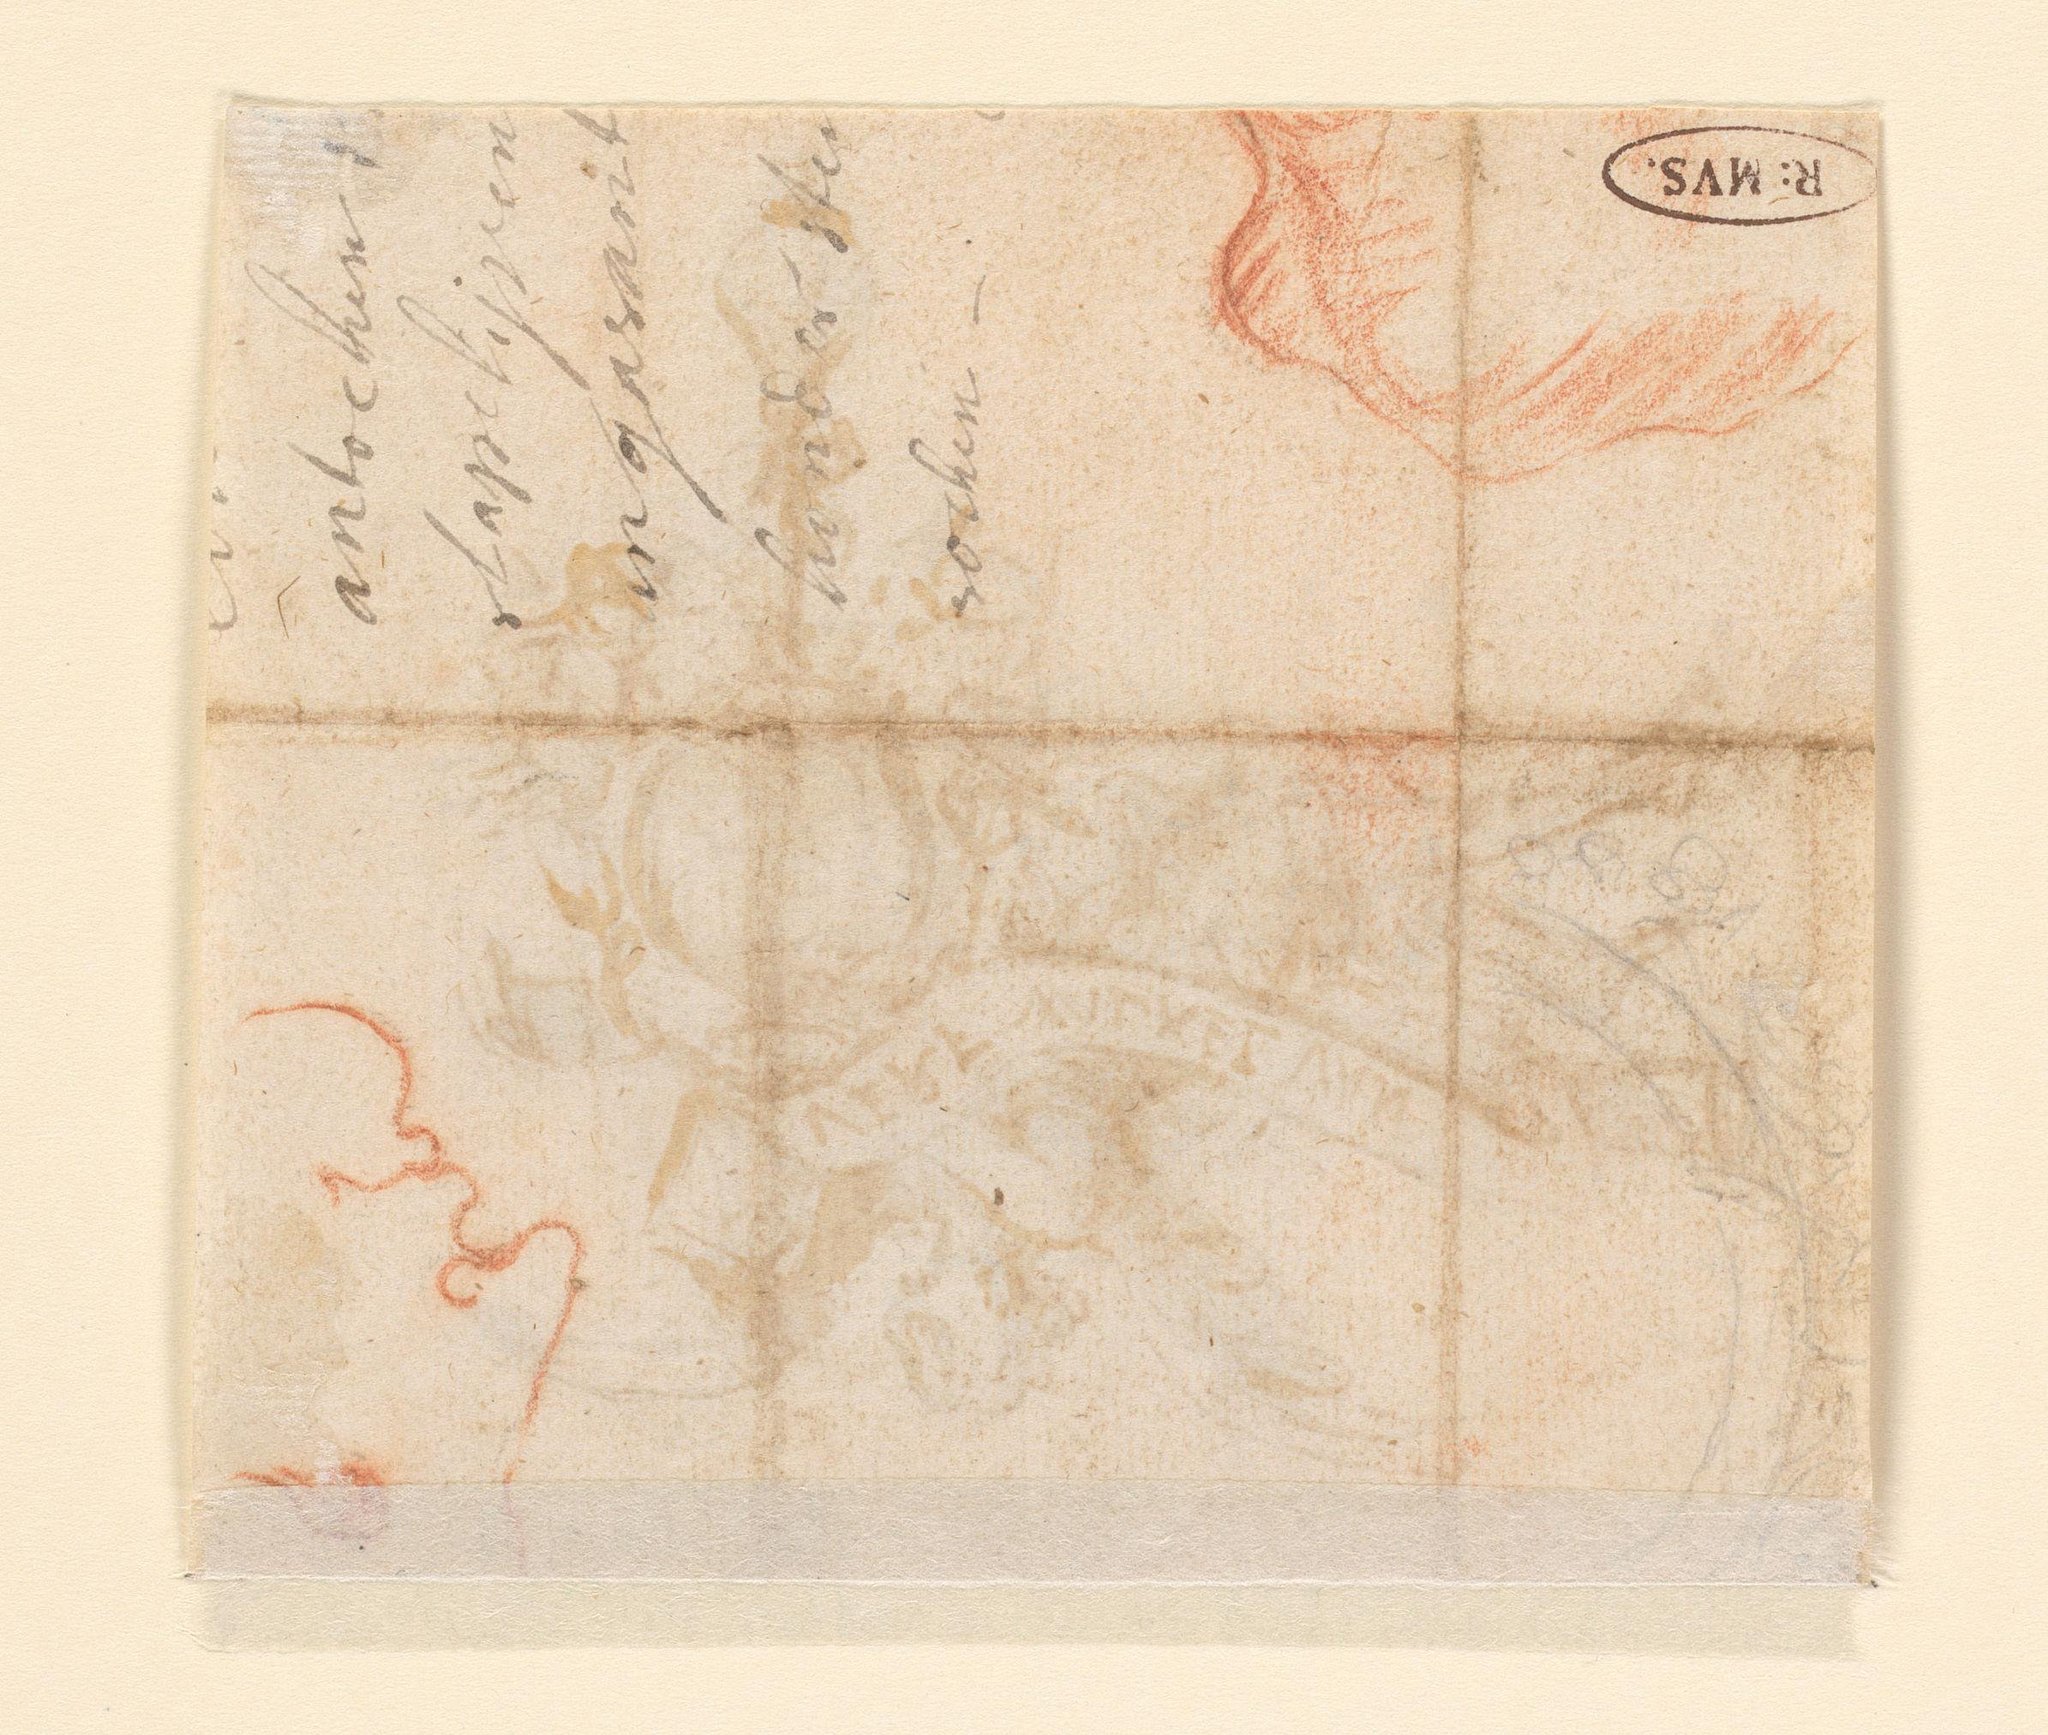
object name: ornamenttekening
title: Twee hoofden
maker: Anonymous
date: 1600-1800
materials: chalk, paper, pencil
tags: head (human)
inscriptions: collector's mark: Lugt 2228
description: Twee schetsen van hoofden en een handgeschreven tekst.